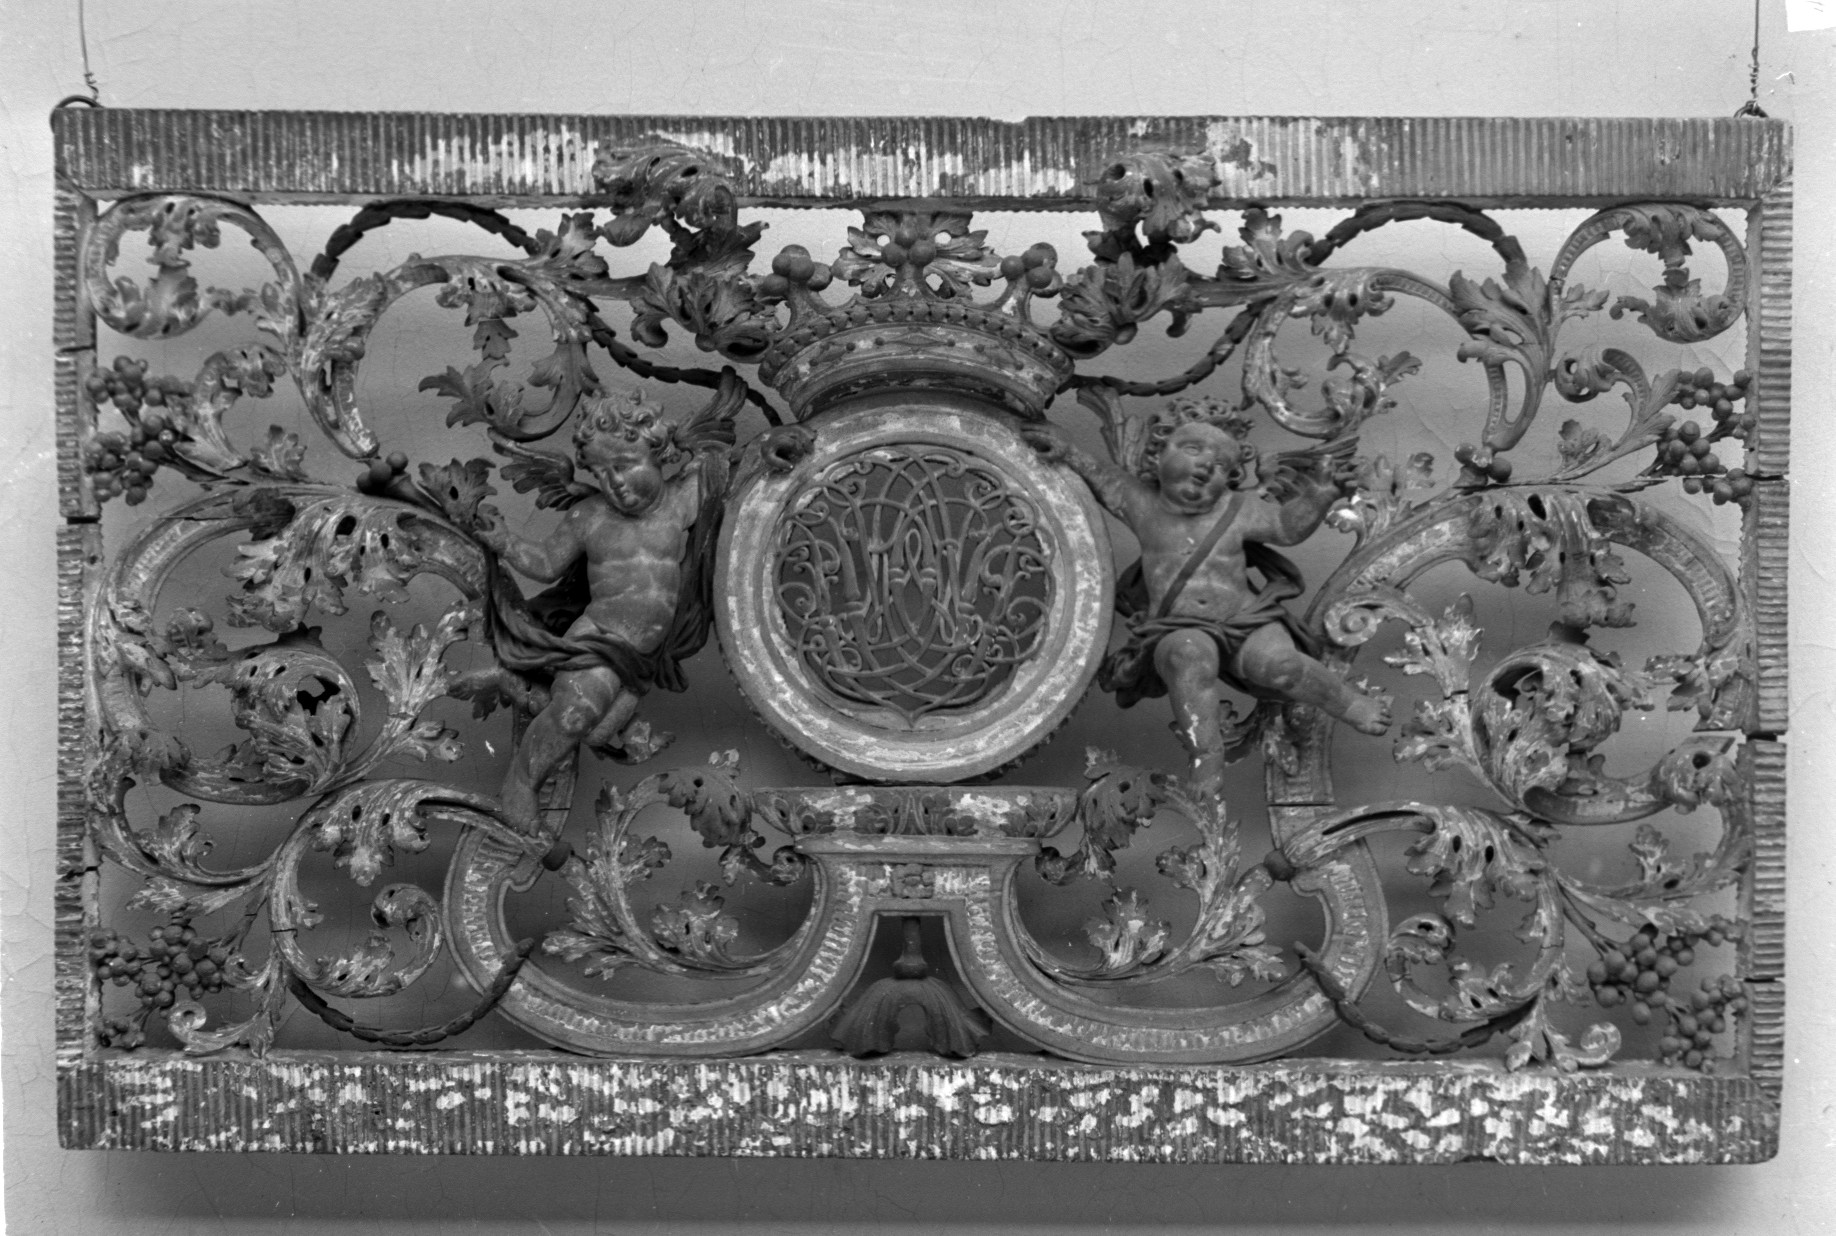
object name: overdoor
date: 1730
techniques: gilding, painting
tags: putti